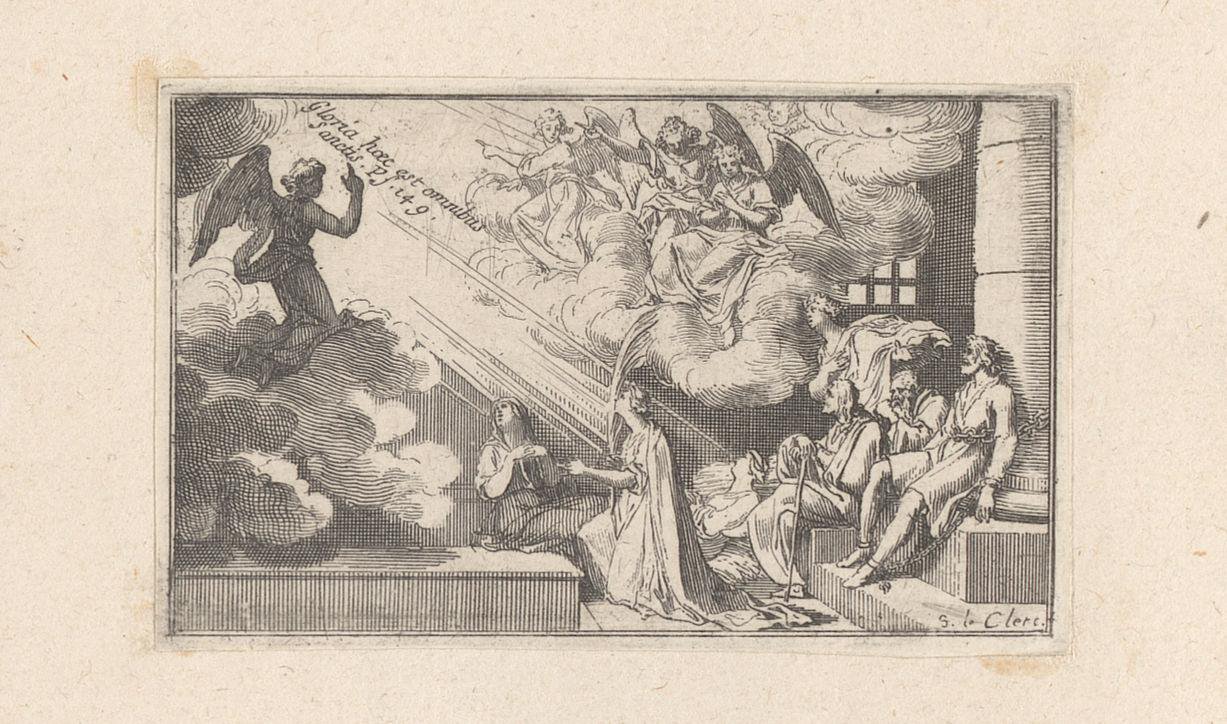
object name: print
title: Vignet met engelen die in een gevangenis verschijnen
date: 1684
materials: paper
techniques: etching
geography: paris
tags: prison, jail, vignette, angels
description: Prent uit: Rapin, Le P. René. La Vie des predestinez (...). Parijs: Sébastien Mabre-Cramoisy, 1684.